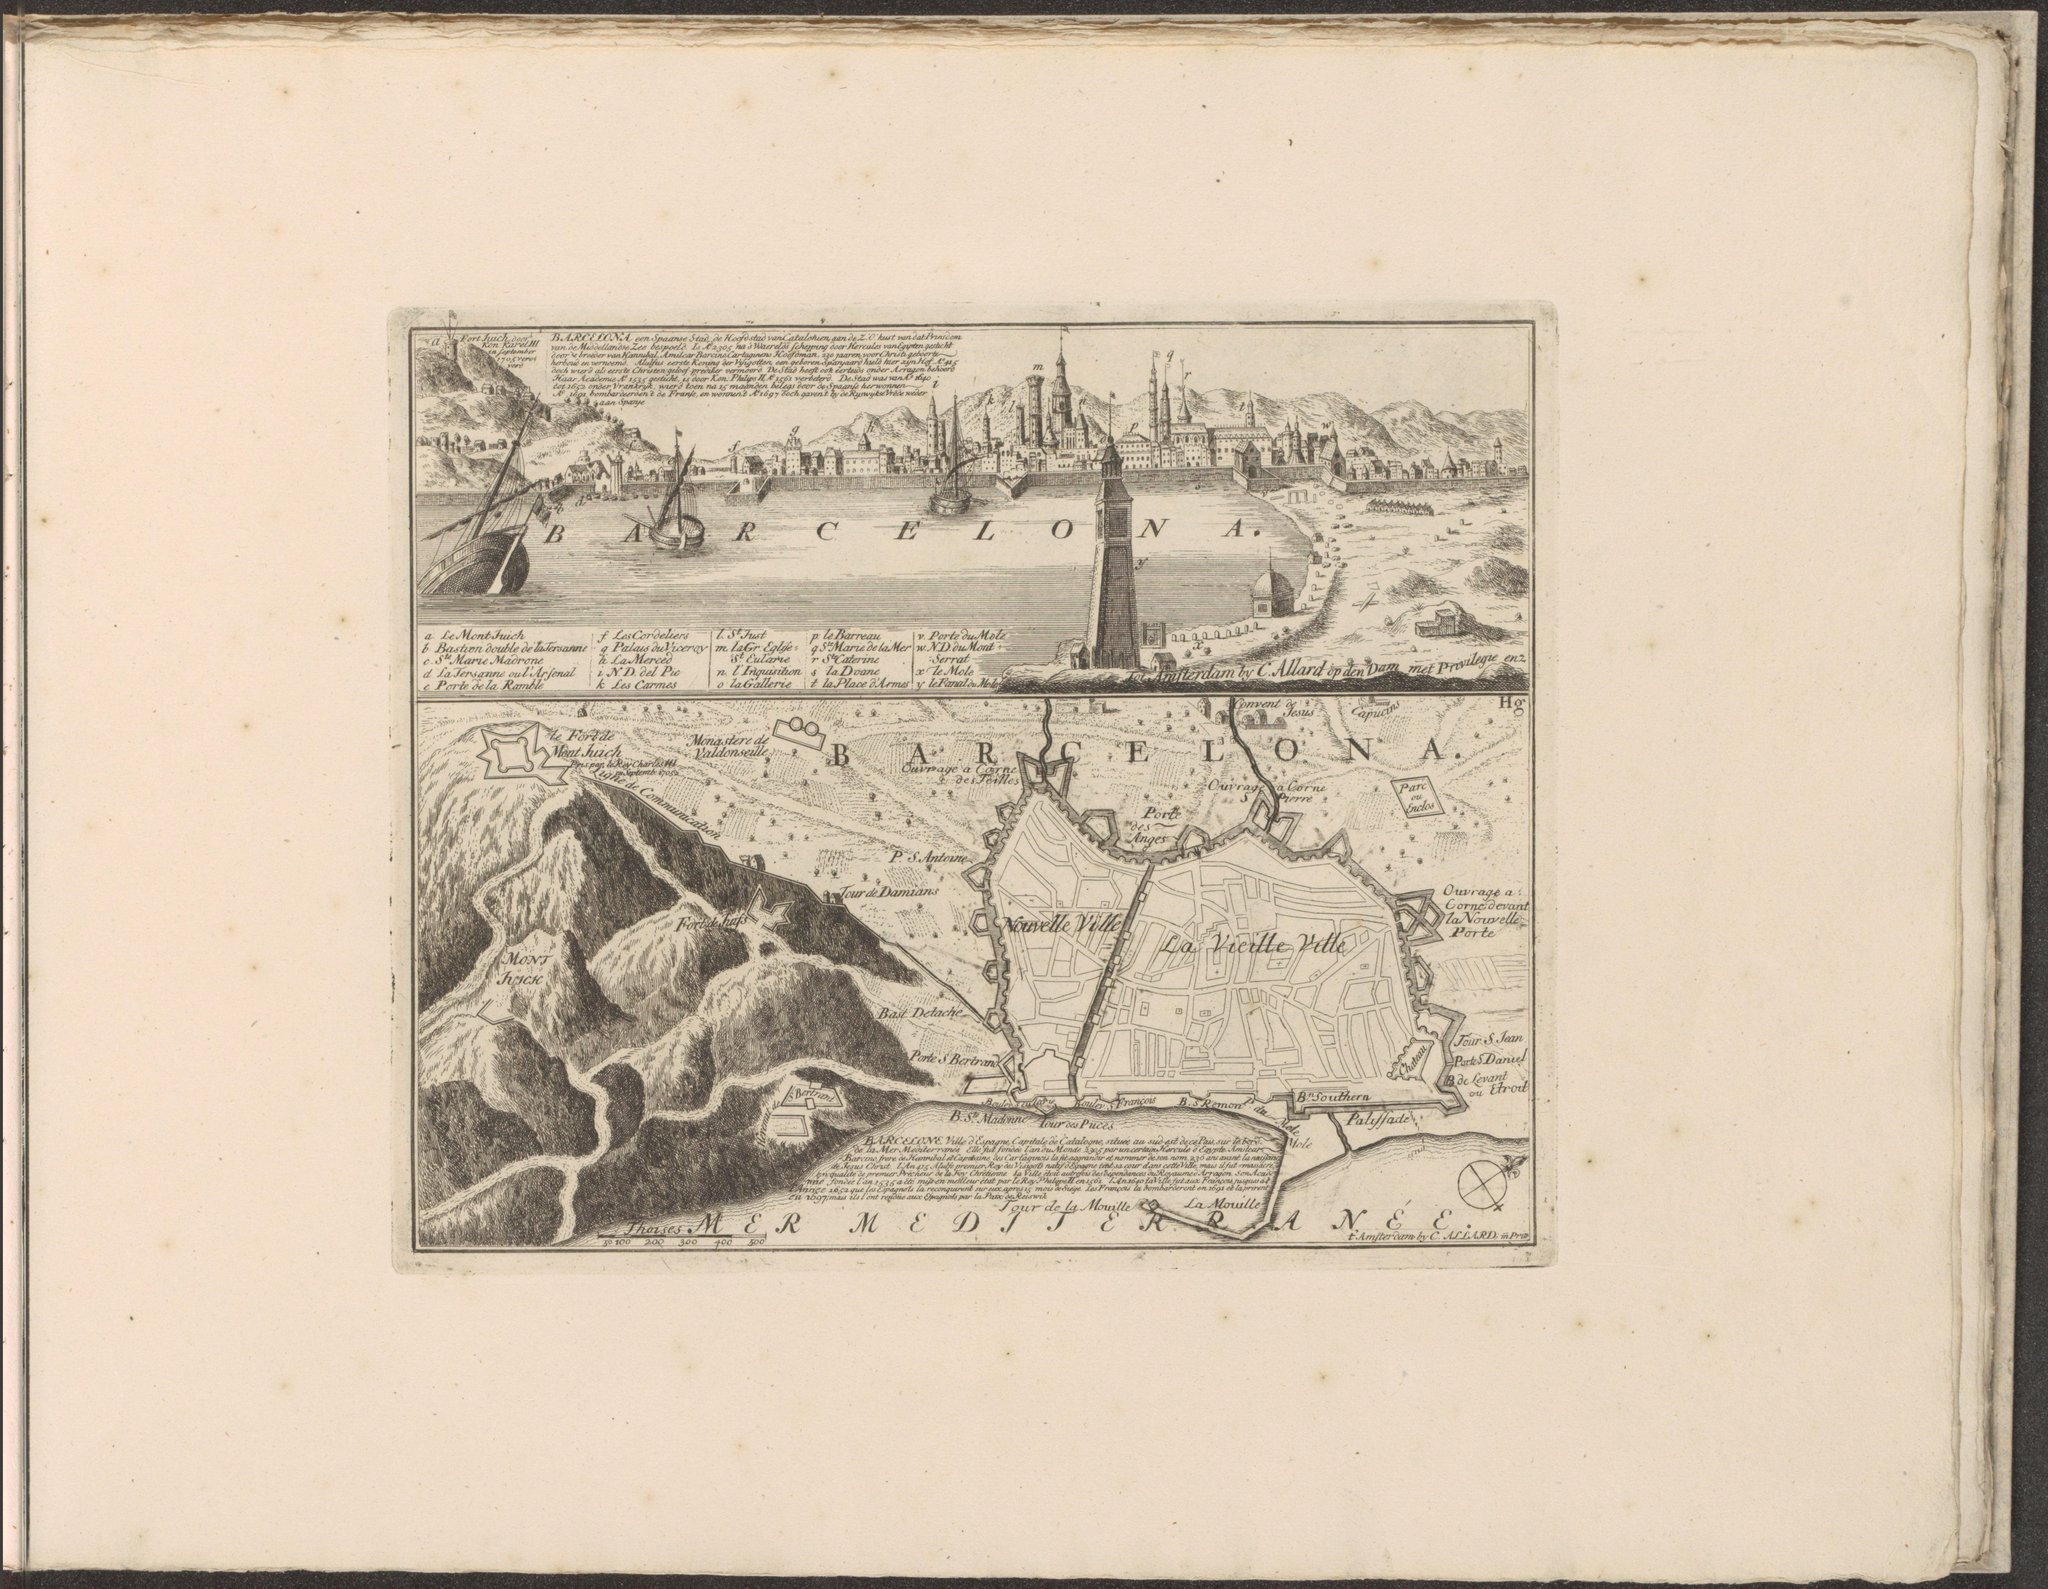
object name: print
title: Barcelona, een Spaanse stad, de hoofdstad van Catalonien (...)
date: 1701-1733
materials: paper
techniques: etching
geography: amsterdam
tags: fortifications, military engineering, maps of cities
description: Gezicht op de stad Barcelona met daaronder een plattegrond van dezelfde stad. Met teksten in het Nederlands en Frans. De prent maakt deel uit van een album.